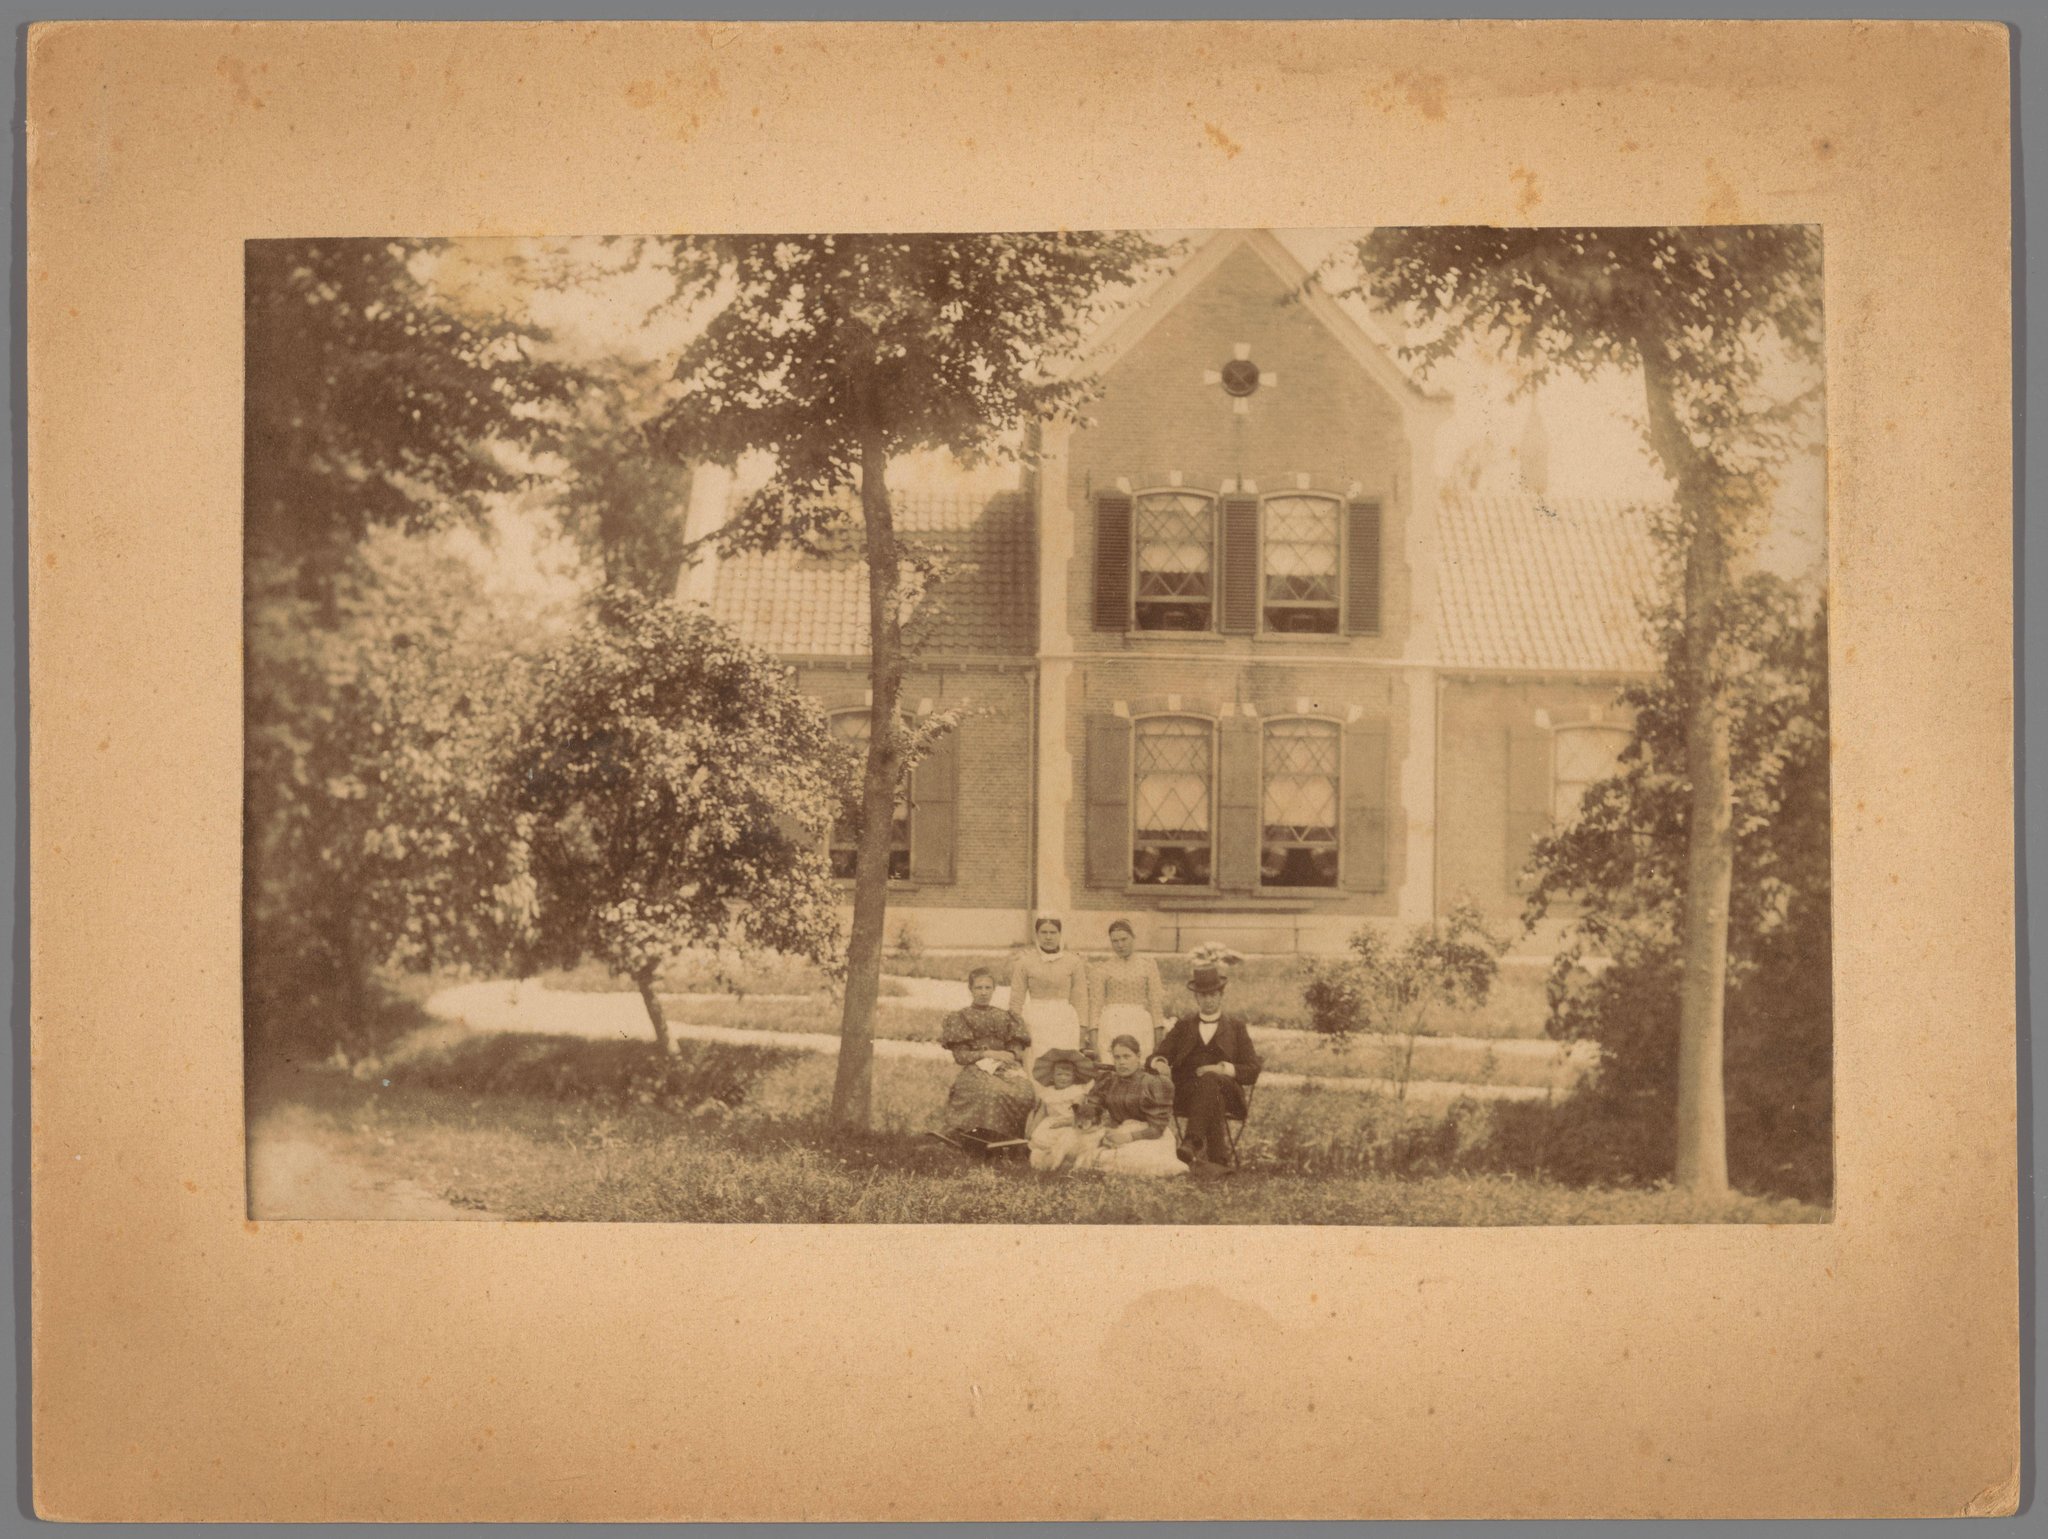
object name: photograph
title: Familieportret van onbekende mensen in een tuin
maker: Anonymous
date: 1880-1910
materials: cardboard, paper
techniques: albumen print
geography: netherlands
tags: family life, anonymous historical persons portrayed in a group, in a group-portrait